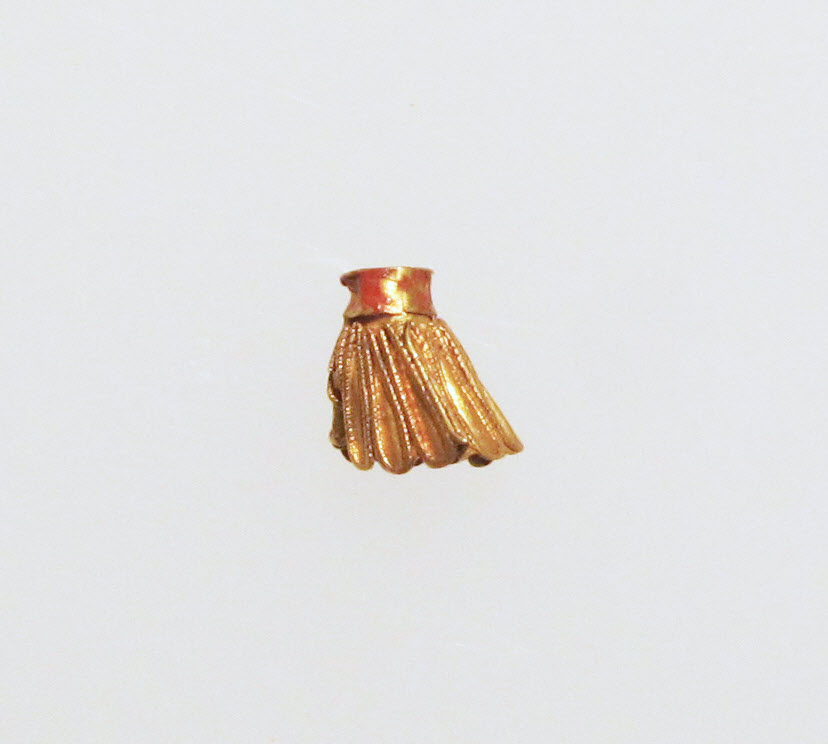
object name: ornament, flower shaped mount for stone bead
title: Ornament, flower-shaped mount for stone bead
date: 7000 BCE-330 CE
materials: gold